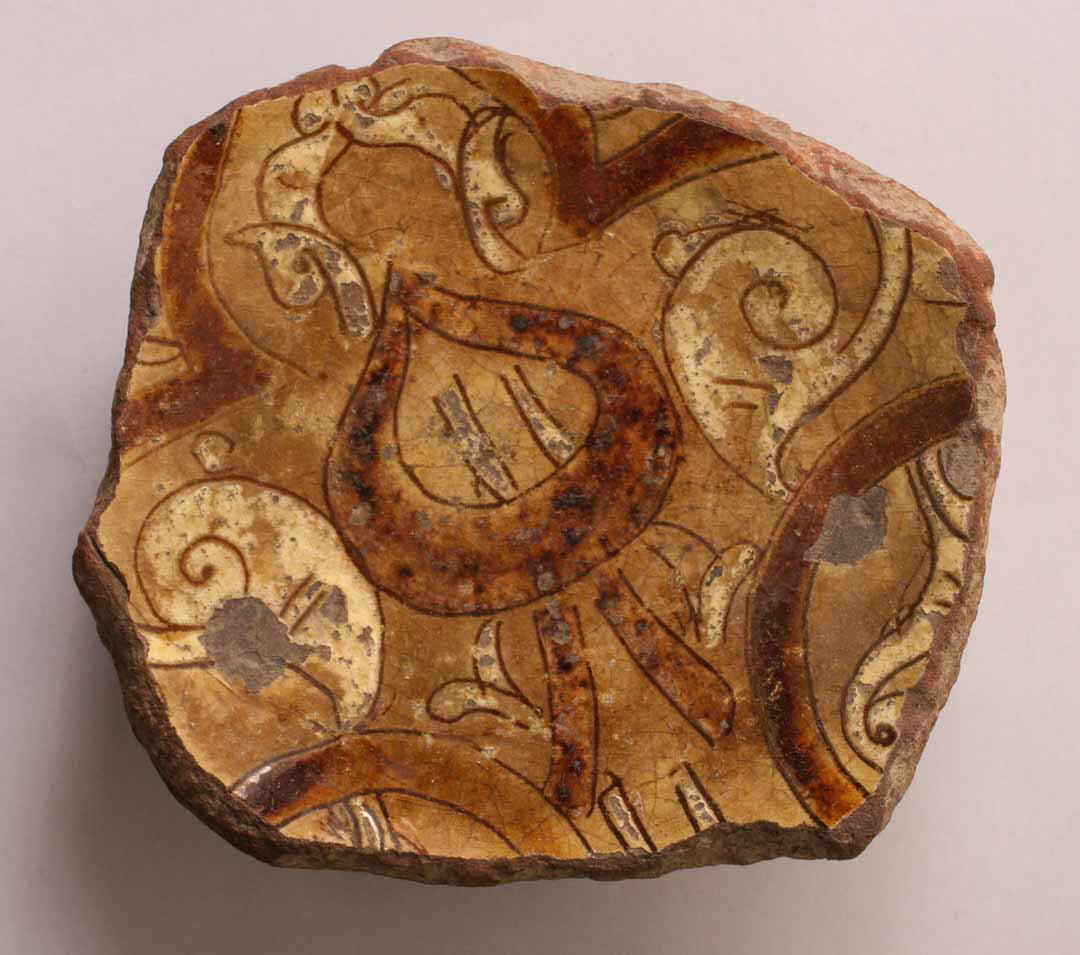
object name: fragment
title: Ceramic Fragment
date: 1301-1500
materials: earthenware, glaze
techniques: coloring, incising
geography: egypt